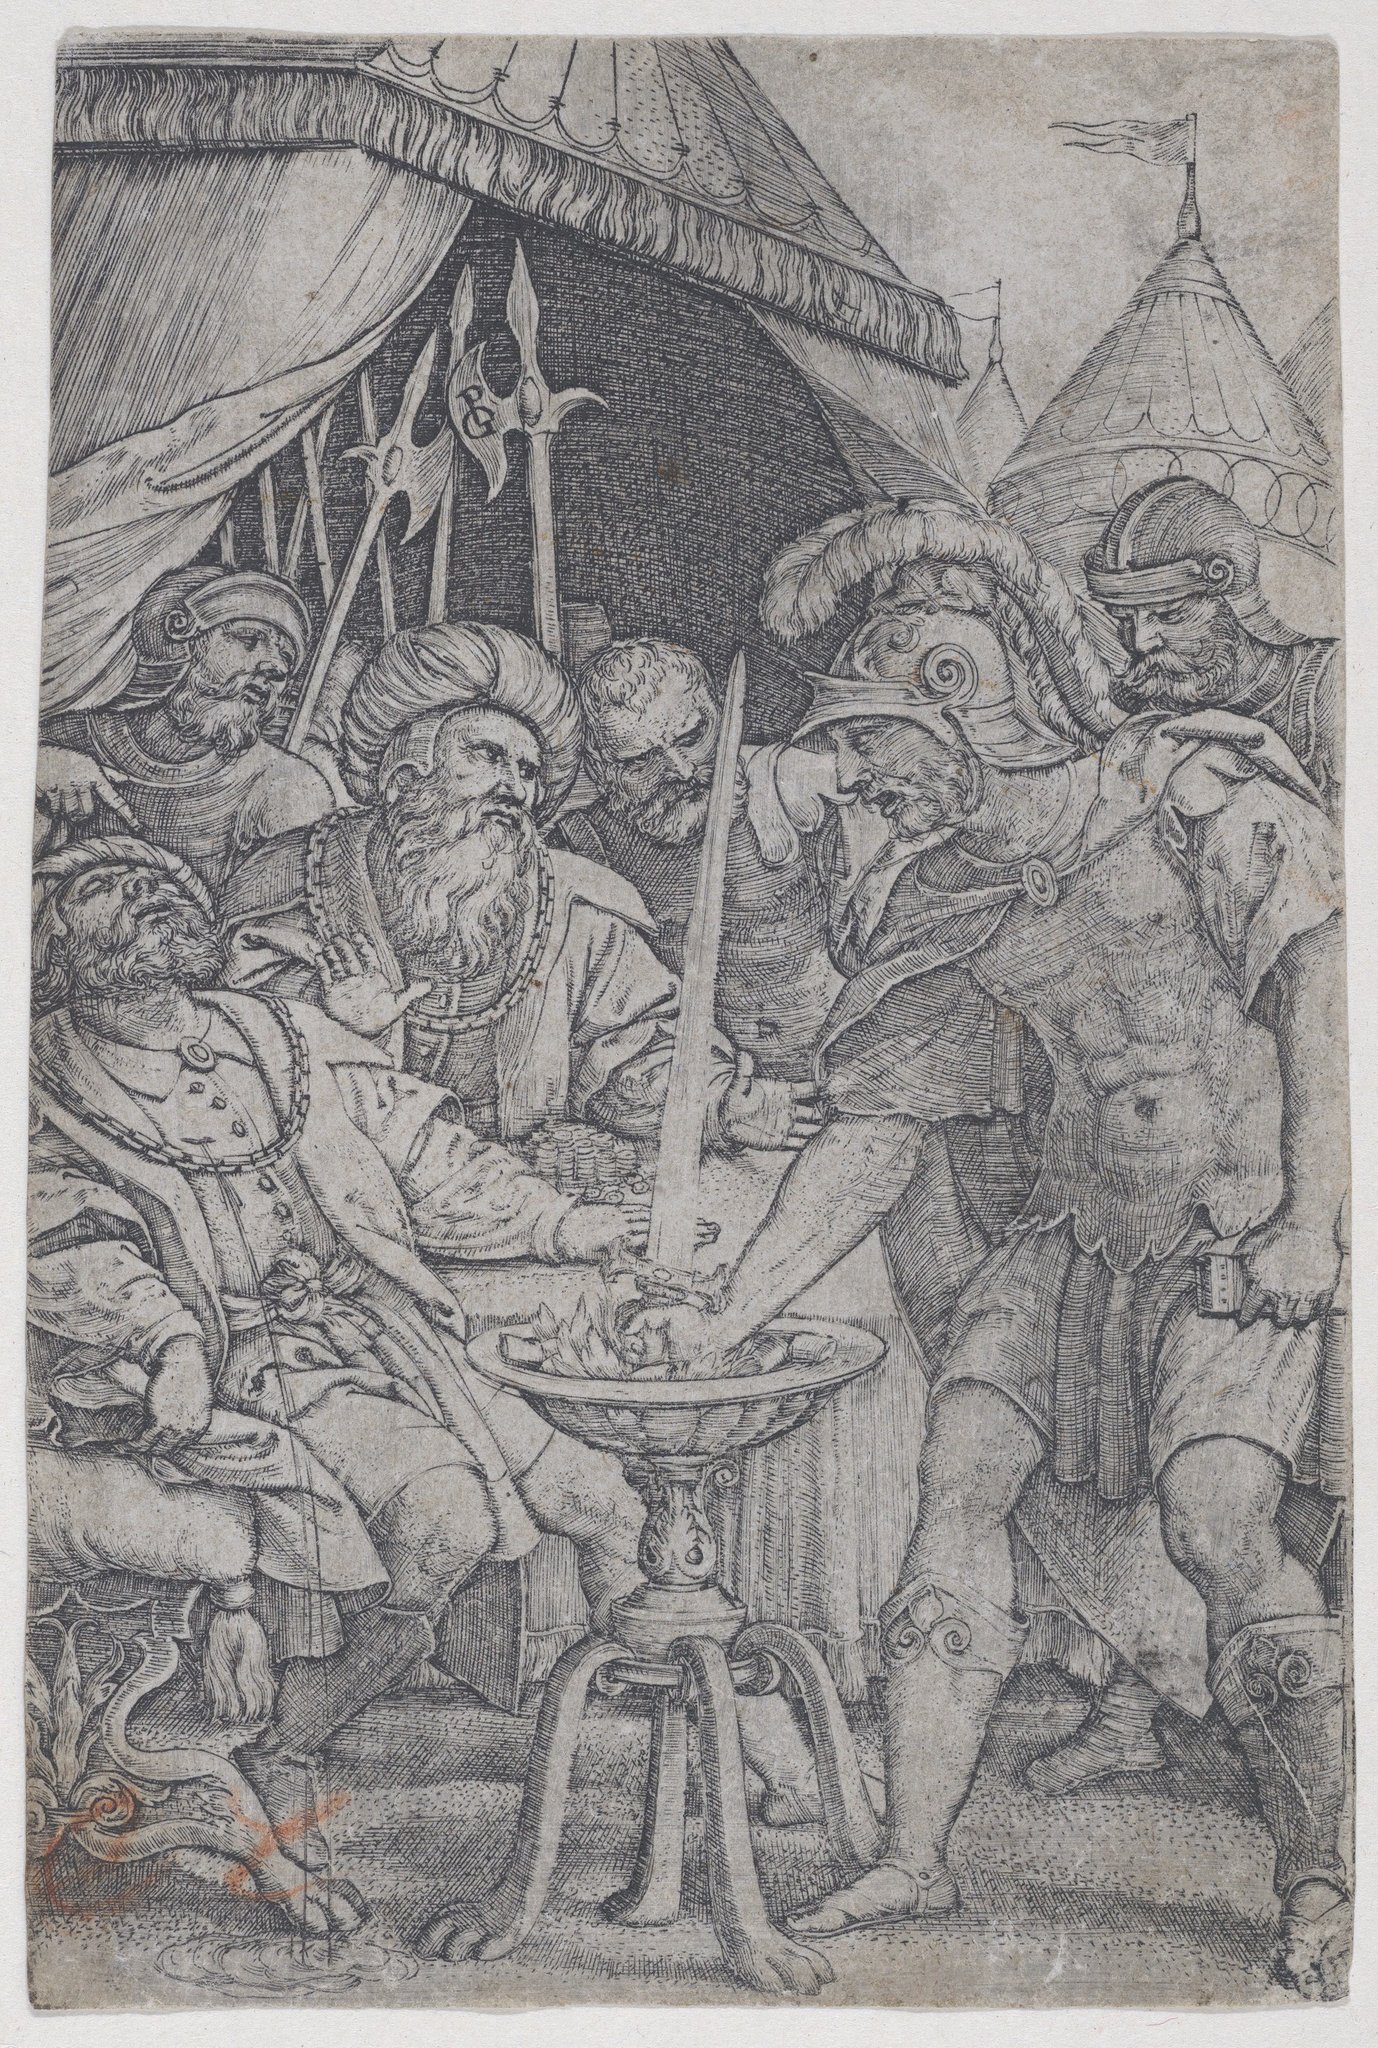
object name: print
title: Mucius Scaevola and Porsenna, from "Roman Heroes"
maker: georg pencz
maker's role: artist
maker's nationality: german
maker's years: 1500-1550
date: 1535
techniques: engraving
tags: swords,men